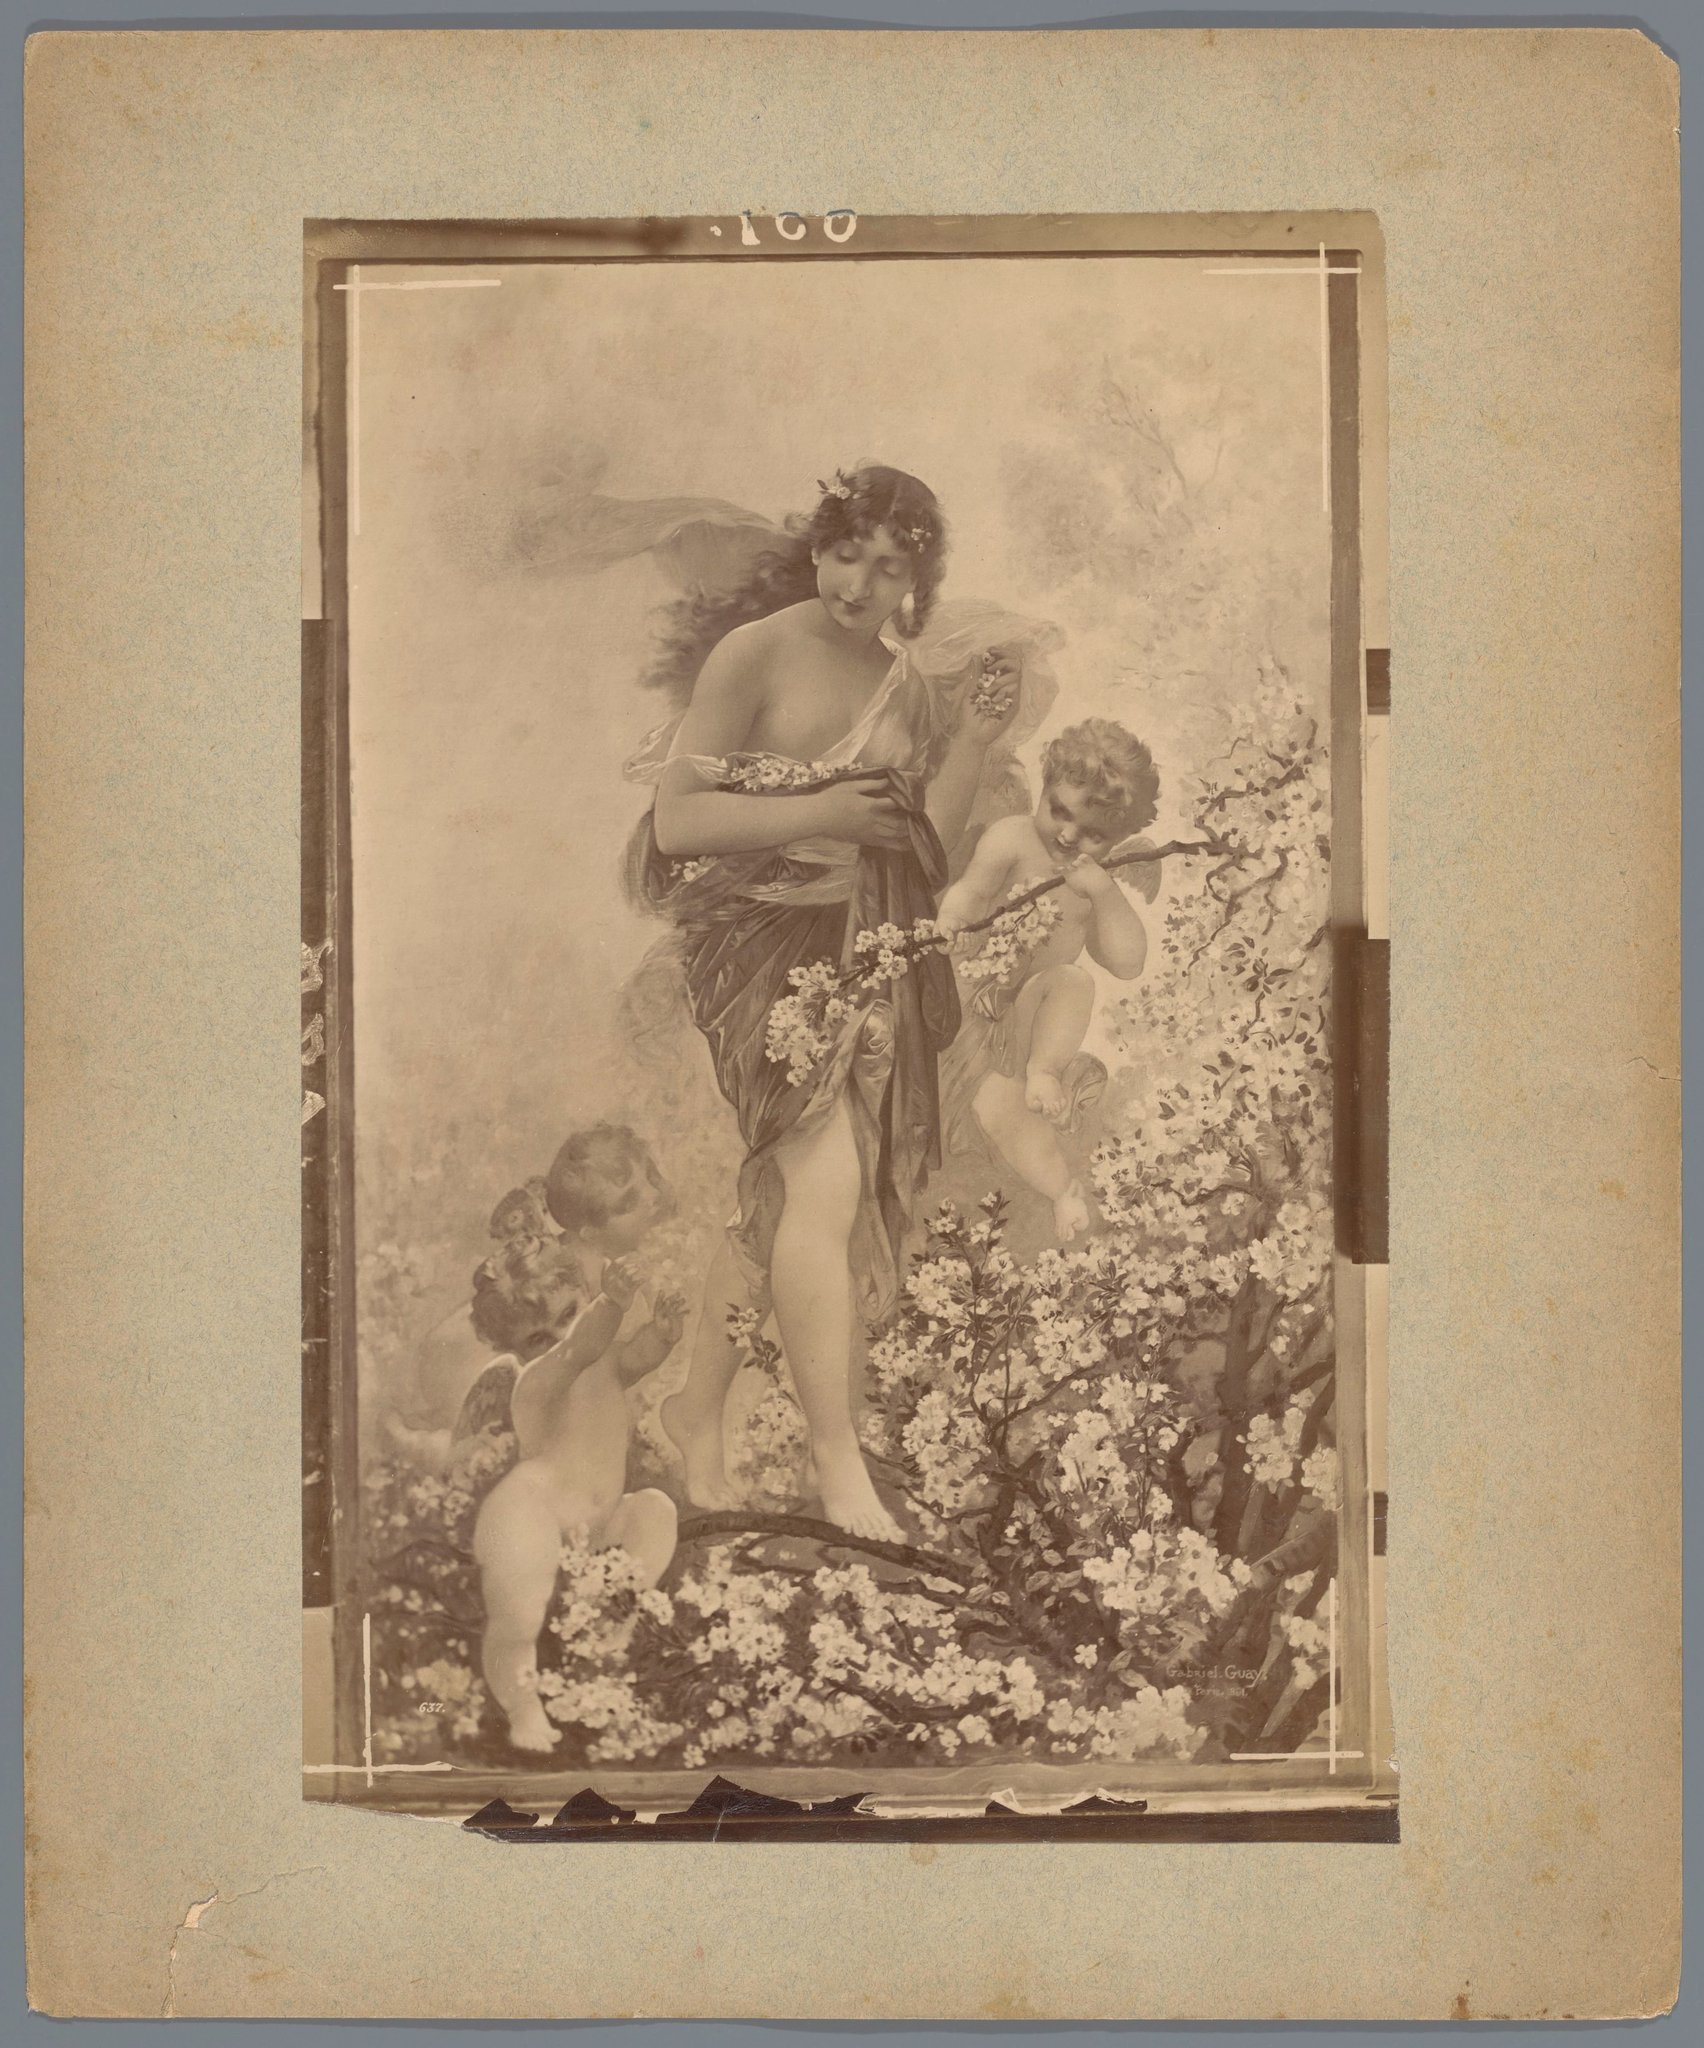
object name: photograph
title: Fotoreproductie van een schilderij, voorstellende een half ontblote vrouw met putti tussen bloemen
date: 1881-1900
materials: cardboard, photographic support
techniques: albumen print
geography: europe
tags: flowers, woman (showing herself) undressed, quasi-nude, cupids: 'amores', 'amoretti', 'putti', europe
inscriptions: collector's mark: Lugt 3937, number: ‘637.’